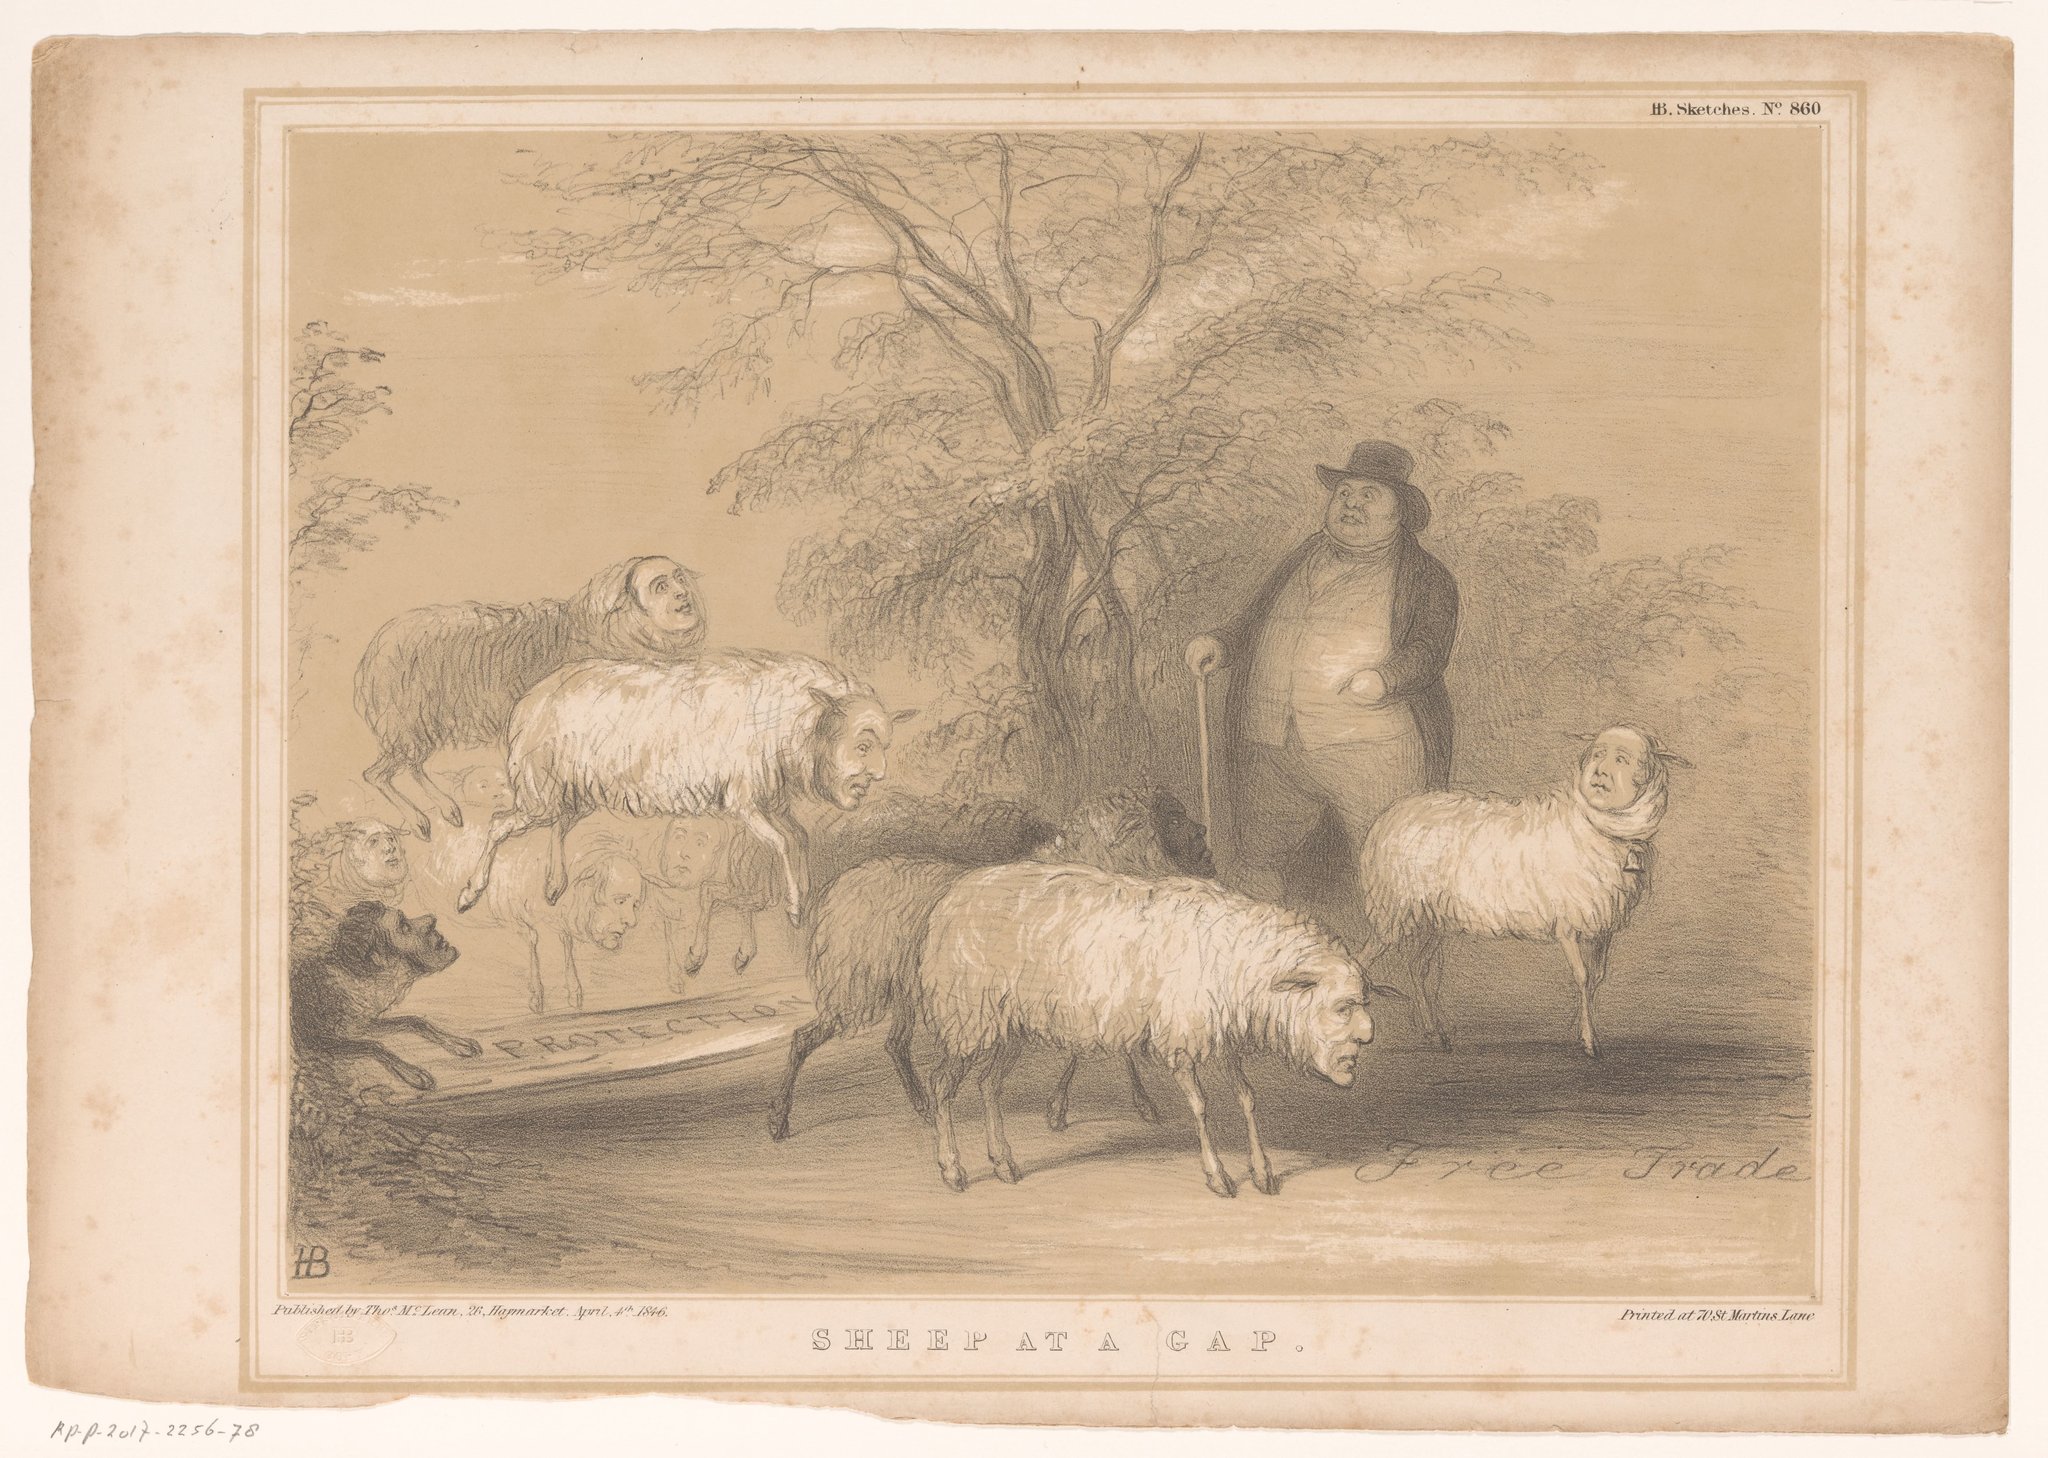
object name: print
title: Spotprent met Britse schapen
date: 1846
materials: paper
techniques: tone lithography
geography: london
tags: personifications of countries, nations, states, districts, etc., sheep, political caricatures and satires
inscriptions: stamp: ‘HB Subscribers Copy’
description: Spotprent uit 1846 waarin een kudde schapen een voor een de hindernis 'protectie' nemen naar vrijhandel toe. John Bull is de herder die toeziet hoe een schaap (premier Peel) over de 'gap' springt. Uitgegeven als nr. 860 in de serie HB Sketches.